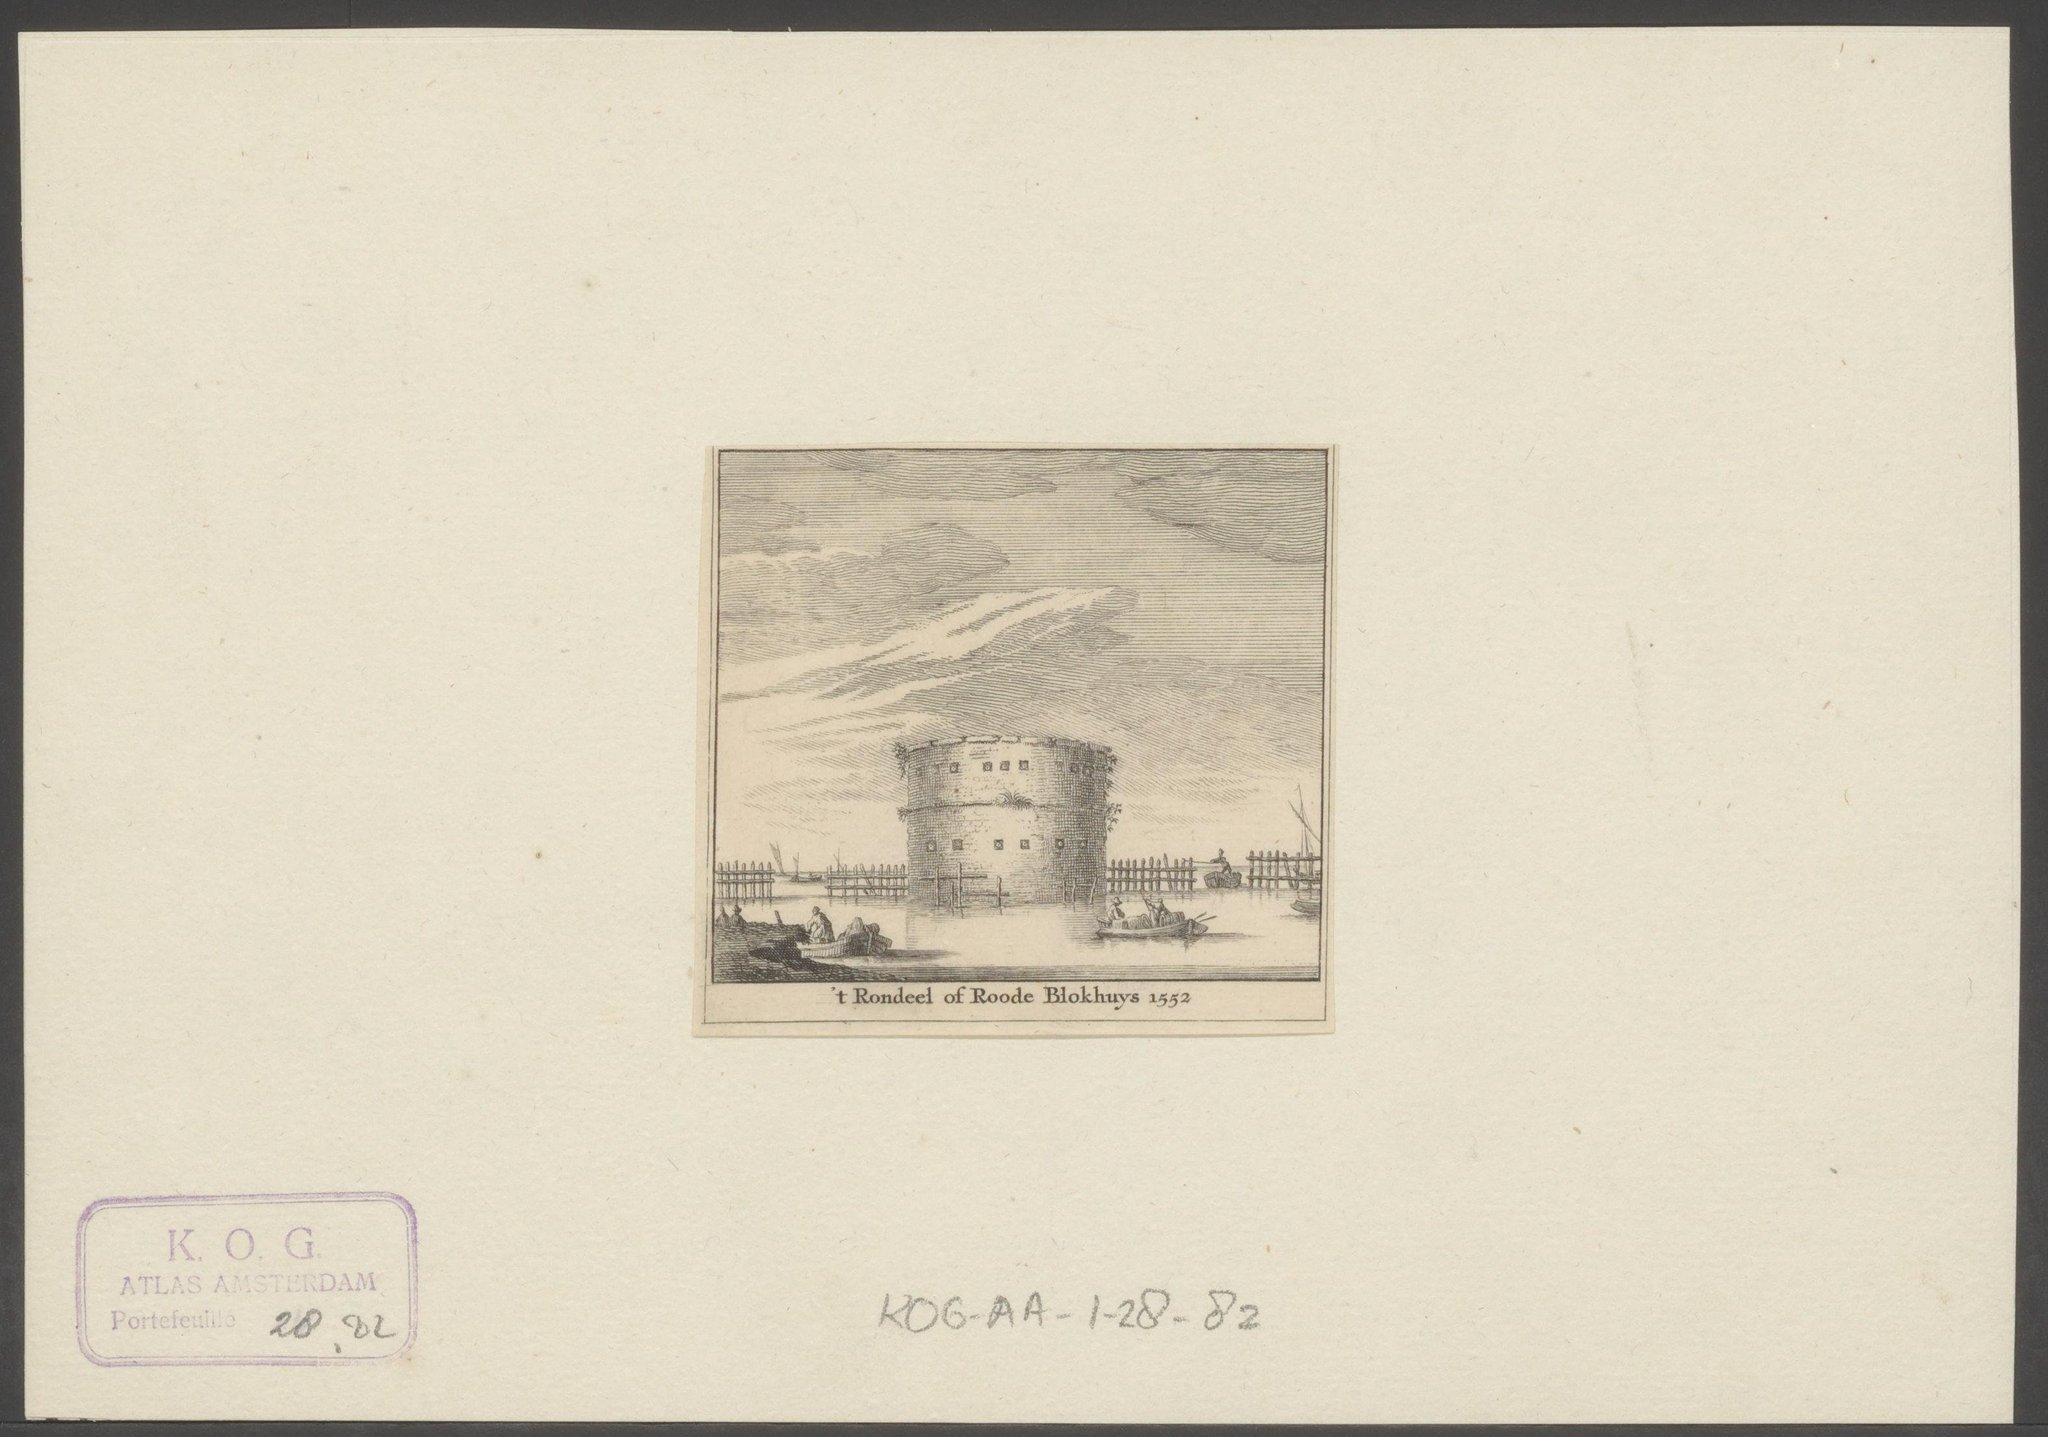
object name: print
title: Gezicht op de het Rode Blokhuis te Amsterdam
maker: jan goeree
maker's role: draughtsman, print maker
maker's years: 1670-1731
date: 1723-1738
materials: paper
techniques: engraving, etching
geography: amsterdam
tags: towers ~ fortified city, rowing-boat, canoe, etc.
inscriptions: collector's mark: Lugt 1641b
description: Prent mogelijk uit: Willink, Daniël. Daniël Willinks Amsterdamsche Buitensingel Nevens de omleggende dorpen, opgeheldert door aanteekeningen (…). Amsterdam: Andries van Damme, 1723. Of uit: Willink, Daniël. Daniël Willinks Amsterdamsche Buitensingel, Nevens de omleggende dorpen, opgeheldert door aanteekeningen (…). Amsterdam: Arend van Huyssteen, 1738.